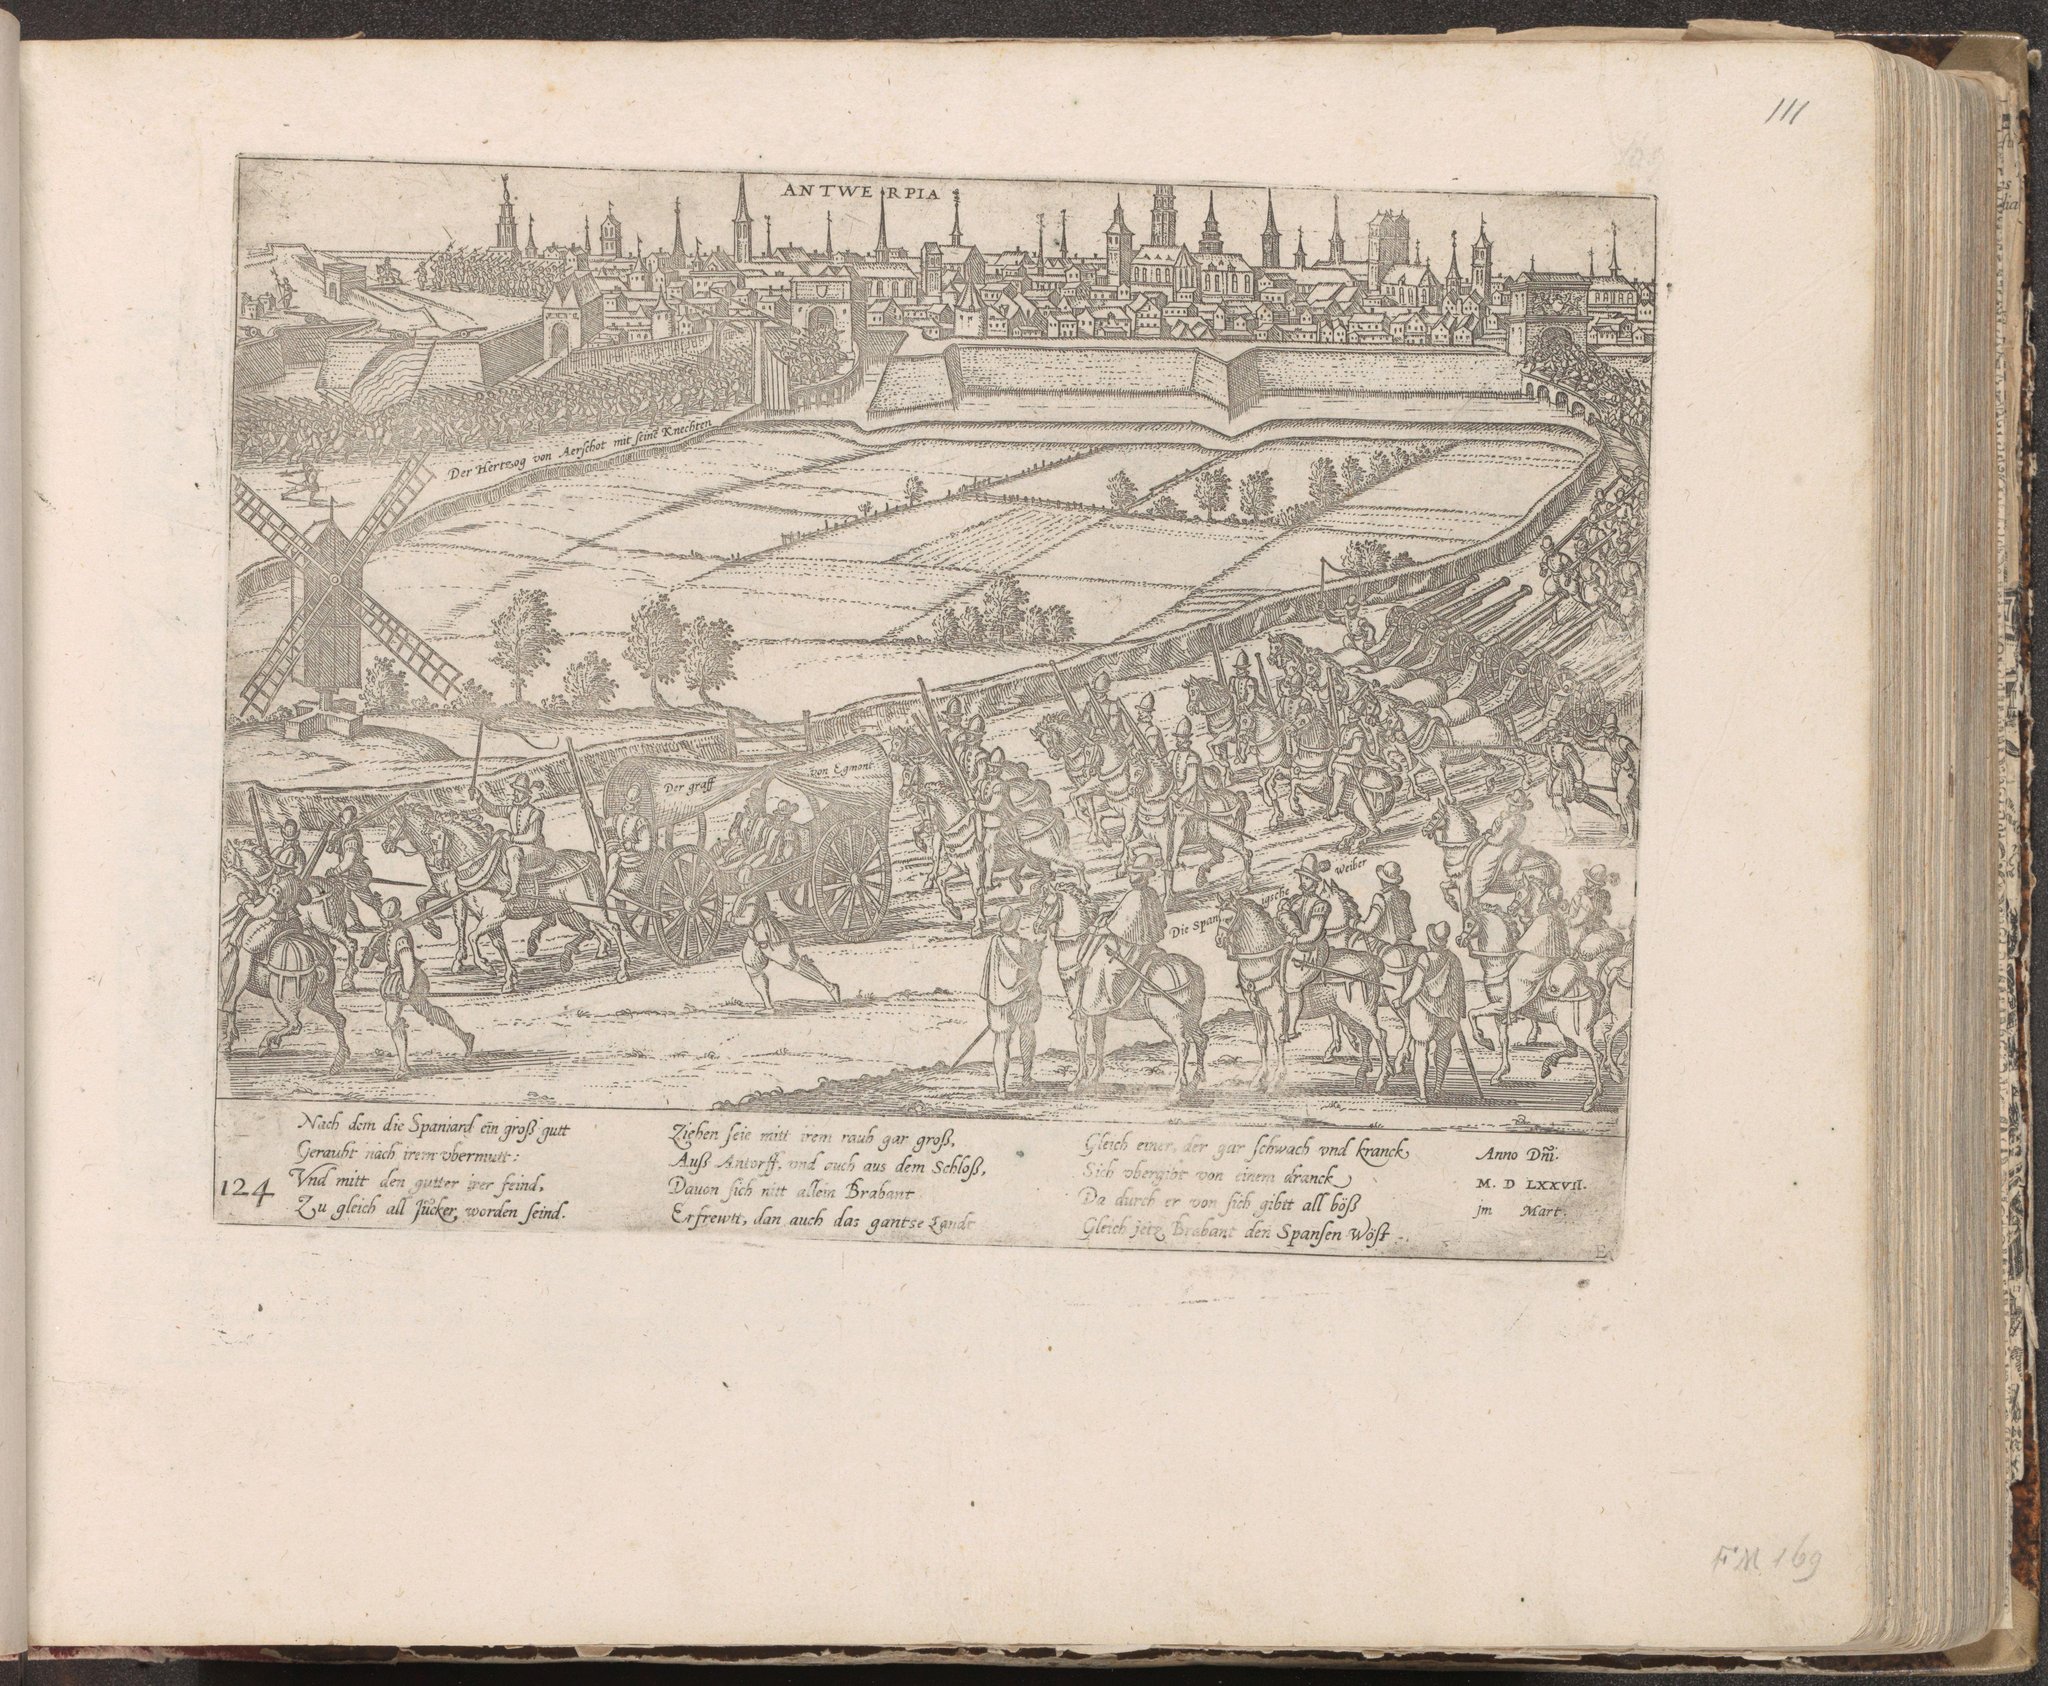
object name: history print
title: Serie 7: Nederlandse Gebeurtenissen, 1576-1577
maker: frans hogenberg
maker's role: print maker, publisher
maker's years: 1538-1590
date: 1577-1579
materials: paper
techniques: etching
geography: cologne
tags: earl, antwerp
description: Vertrek van de Spaanse troepen uit Antwerpen, 20 maart 1577. Een lange stoet van soldaten, ruiters en kanonnen, maar ook vrouwen en kinderen verlaat de stad. Op de voorgrond een koets met de graaf van Egmond. Links op de achtergrond trekken de troepen van de hertog van Aarschot de stad binnen. Met onderschrift van 12 regels in het Duits. Linksonder genummerd: 124. De prent maakt deel uit van een album.